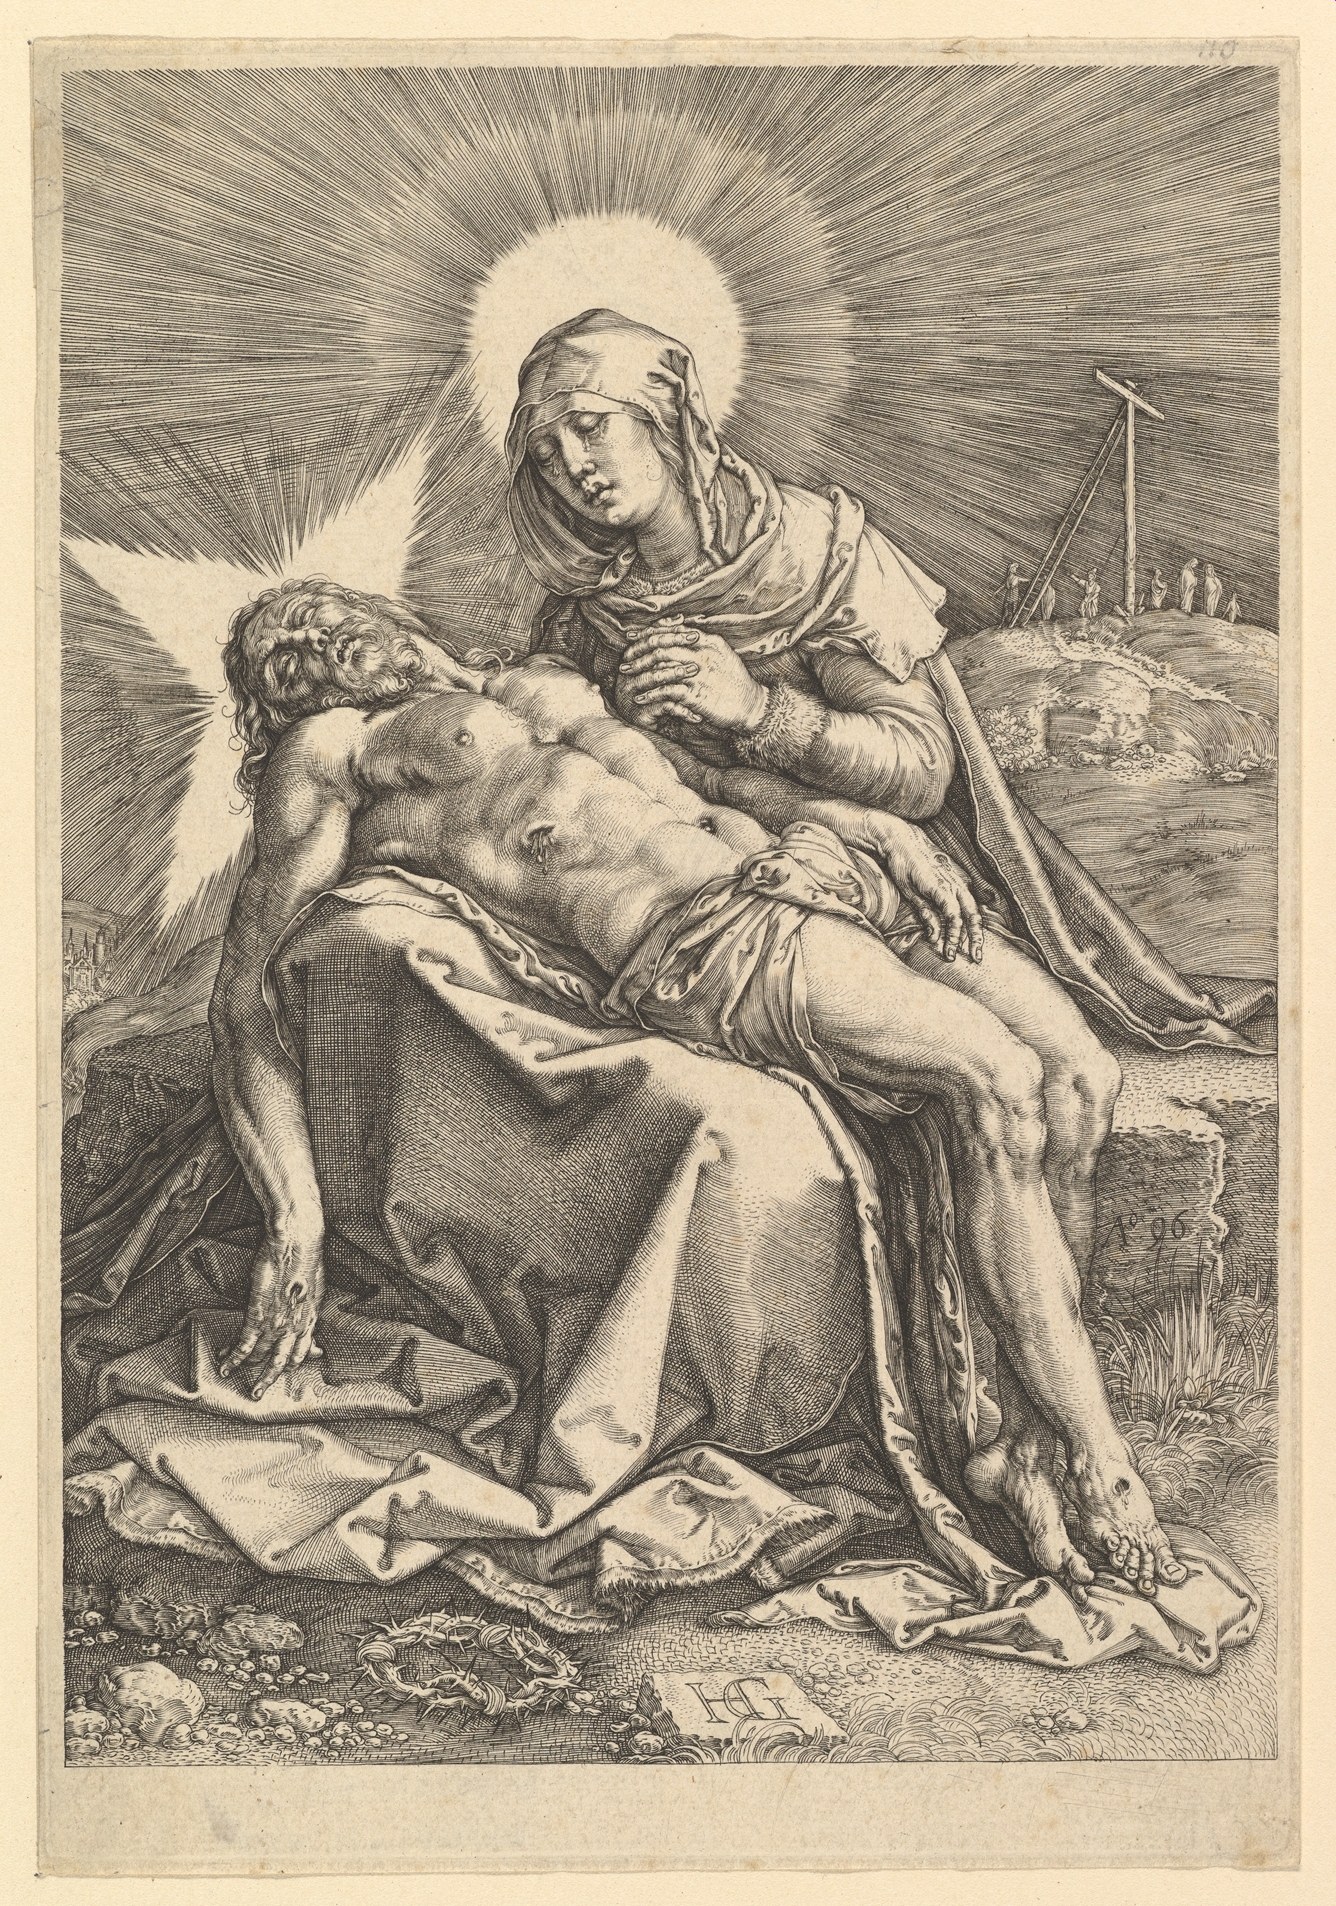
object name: print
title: Pietà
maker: hendrick goltzius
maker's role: artist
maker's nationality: netherlandish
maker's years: 1558-1617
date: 1596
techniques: engraving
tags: virgin mary,jesus